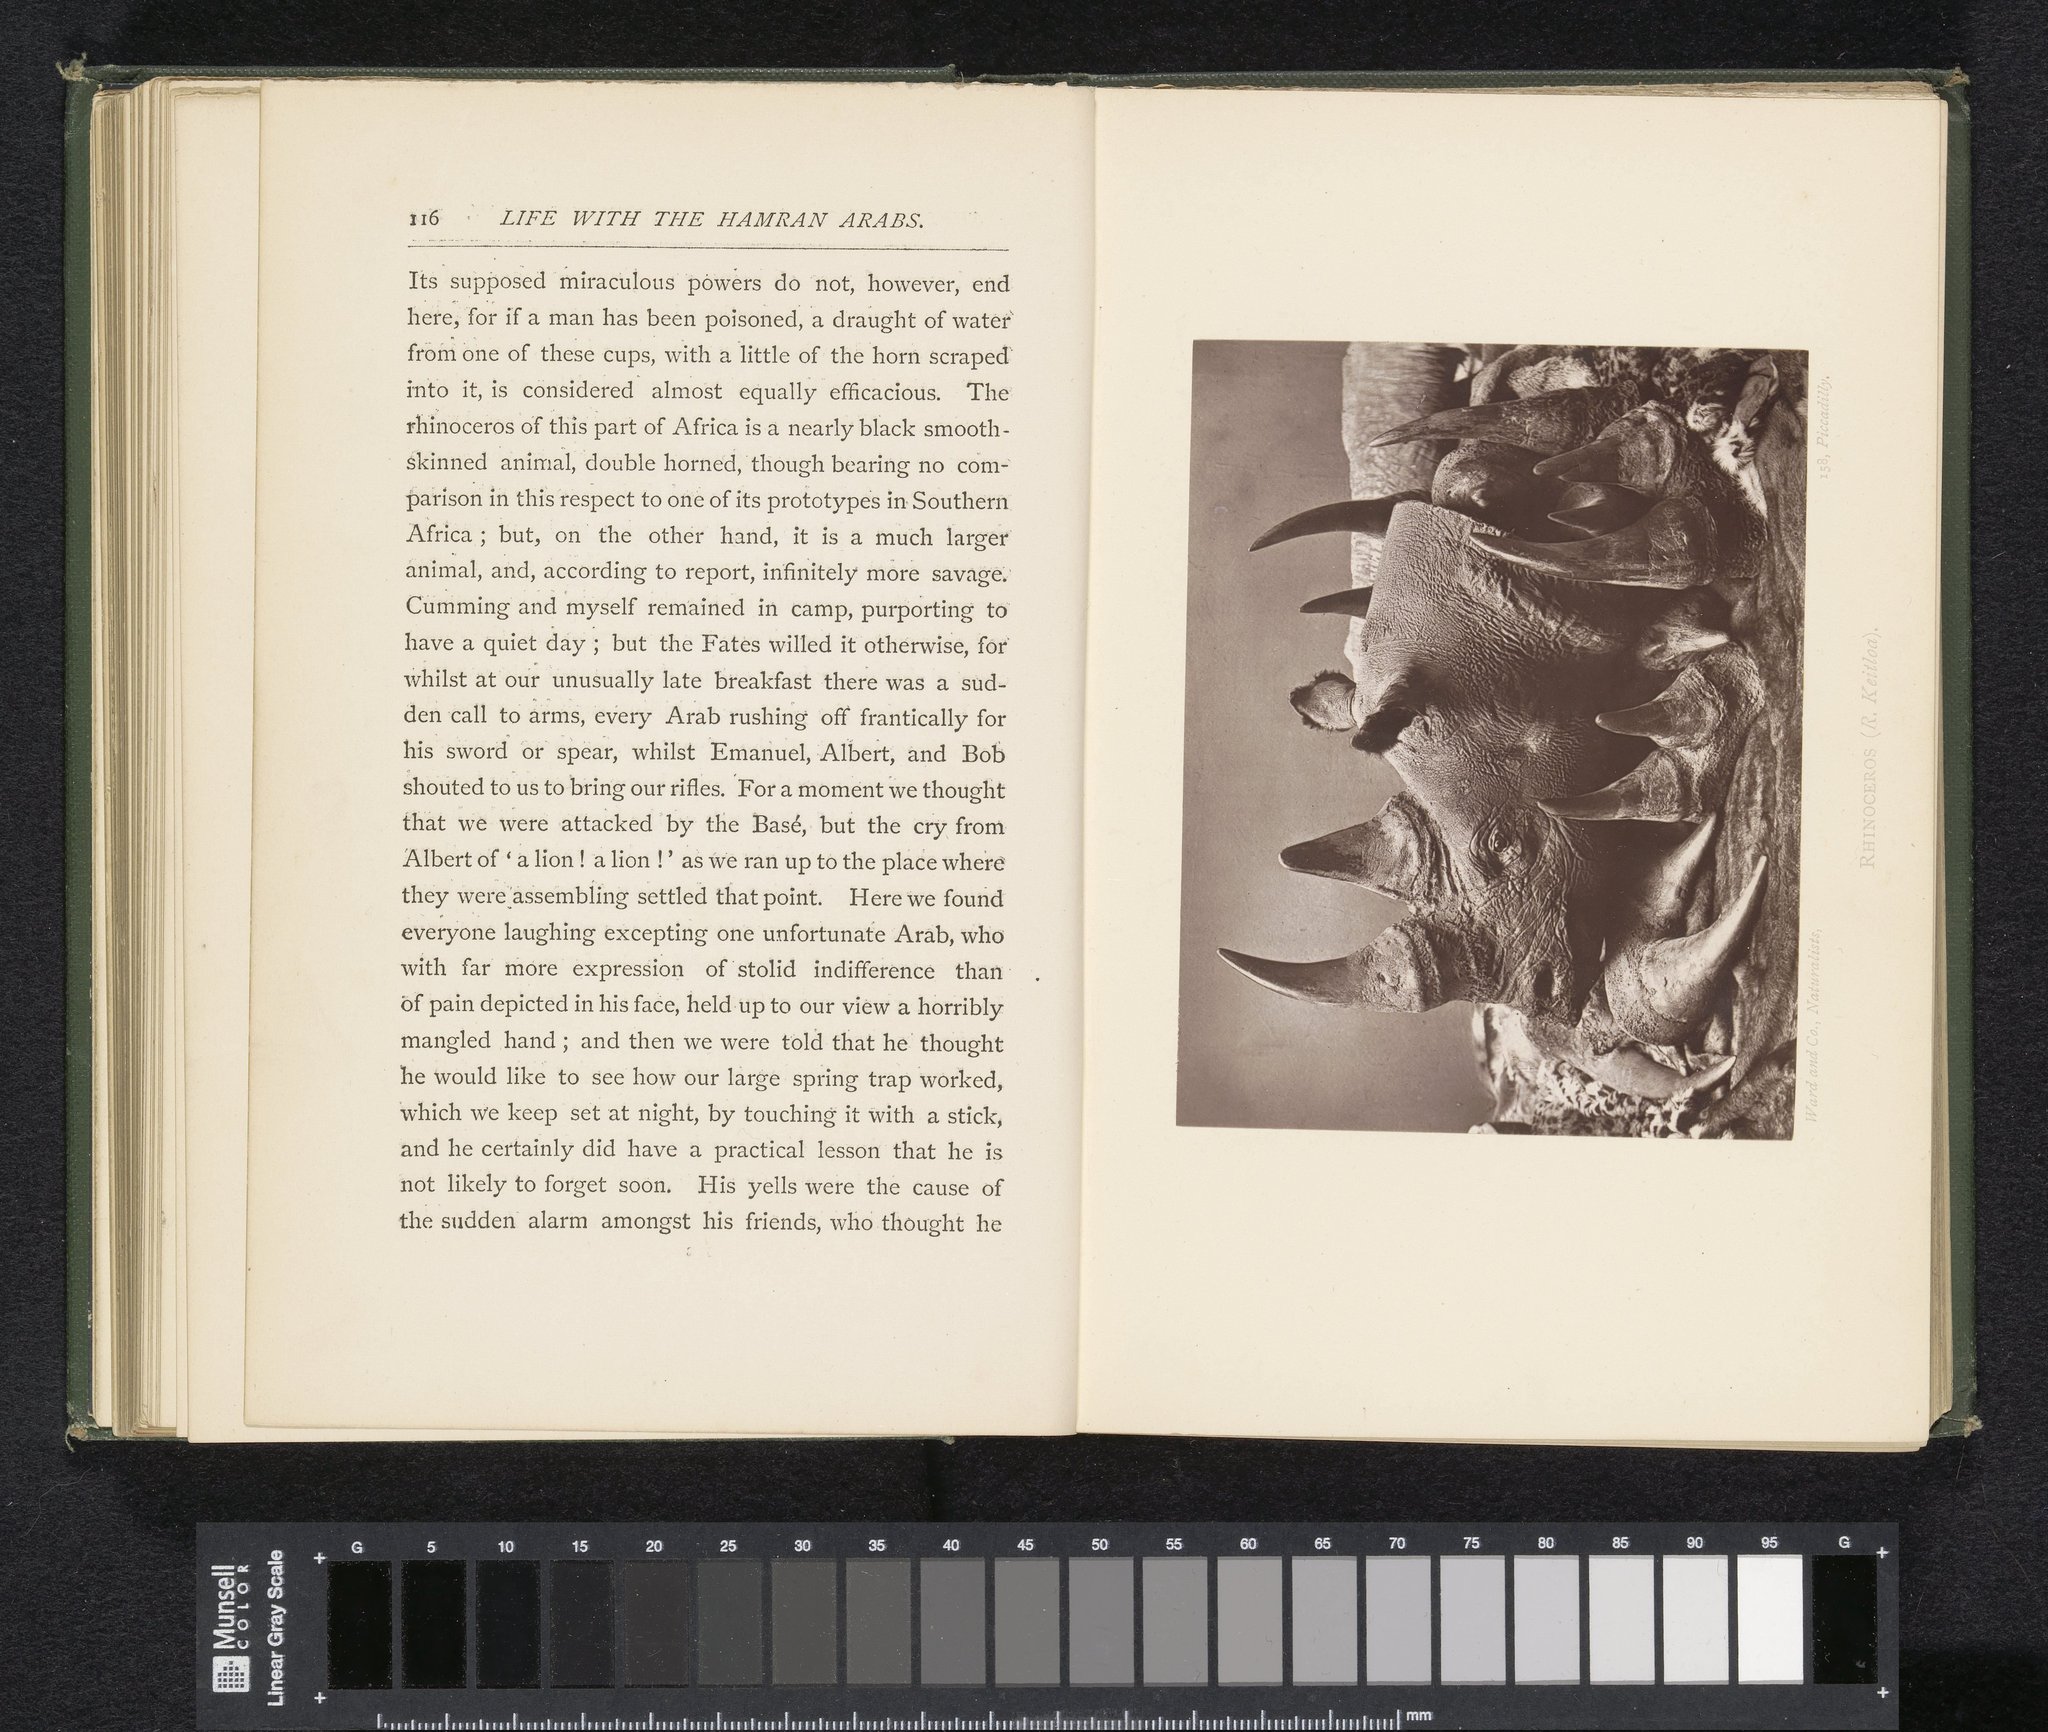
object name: page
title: Rhinoceros (R. Keitloa)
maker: Anonymous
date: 1874-1875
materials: paper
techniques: woodburytype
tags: game, hunted animals, hoofed animals: rhinoceros, hunting trophies